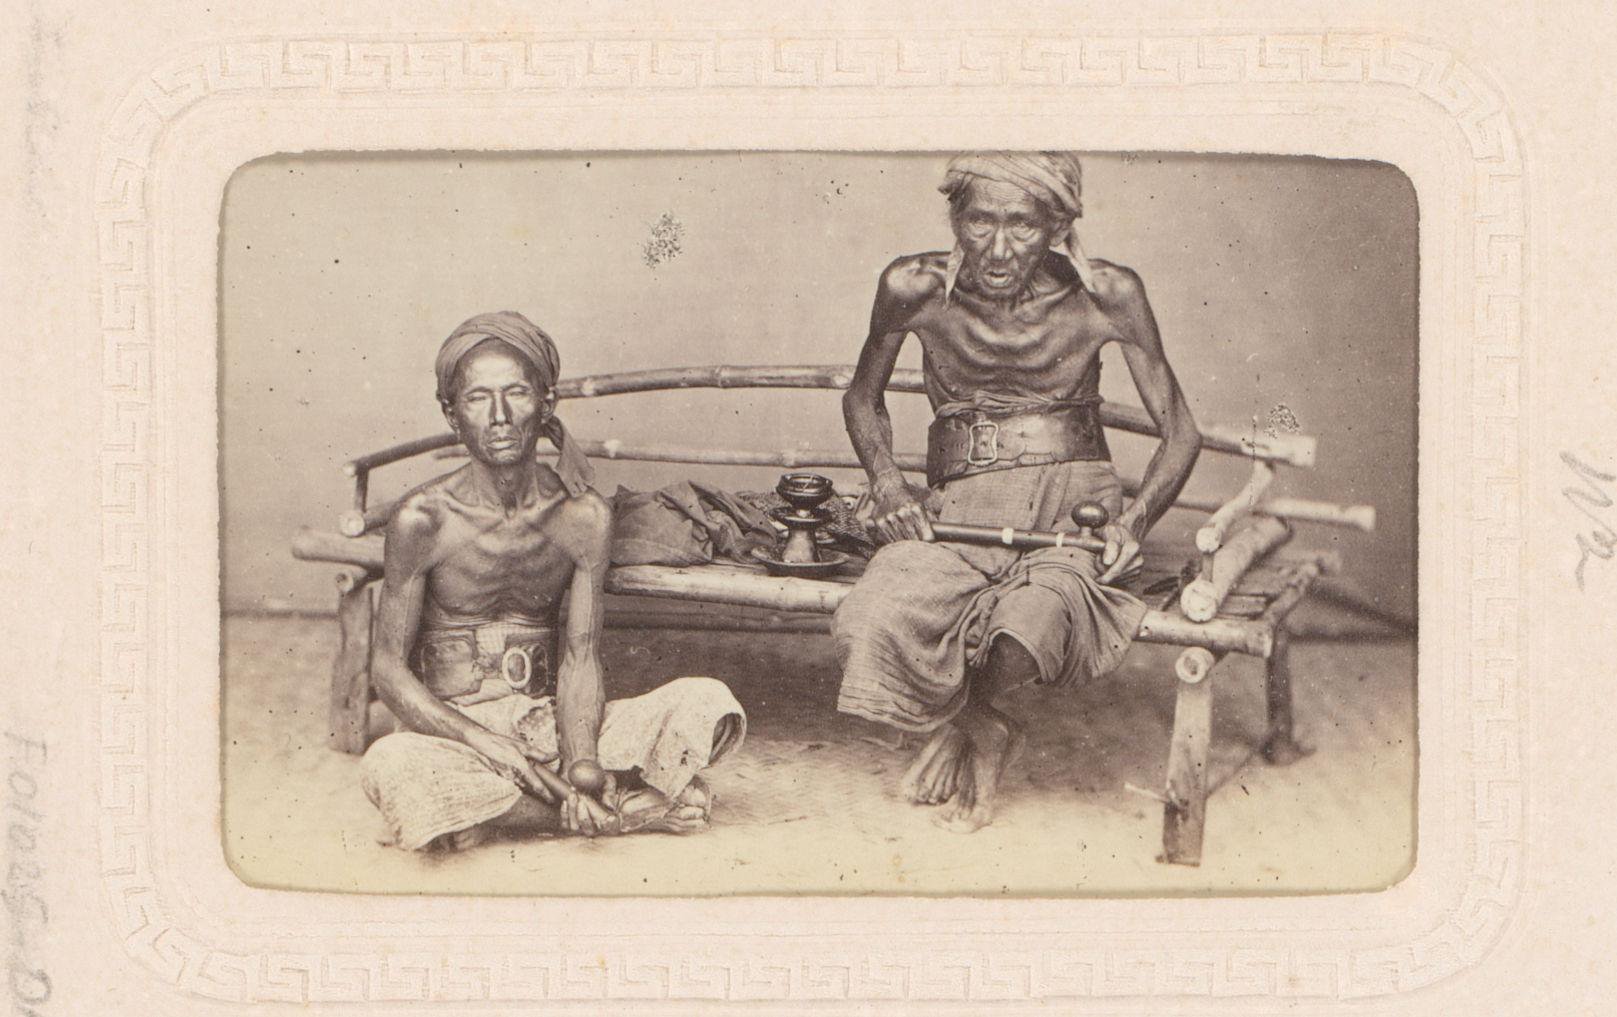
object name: album leaf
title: Portret van twee Indonesische mannen die opium roken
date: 1857-1880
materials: cardboard, photographic support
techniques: albumen print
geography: java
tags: opium-pipe, historical persons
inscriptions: inscription: ‘Woodbury & Page/ Photographers/ Java’, number: ‘112’